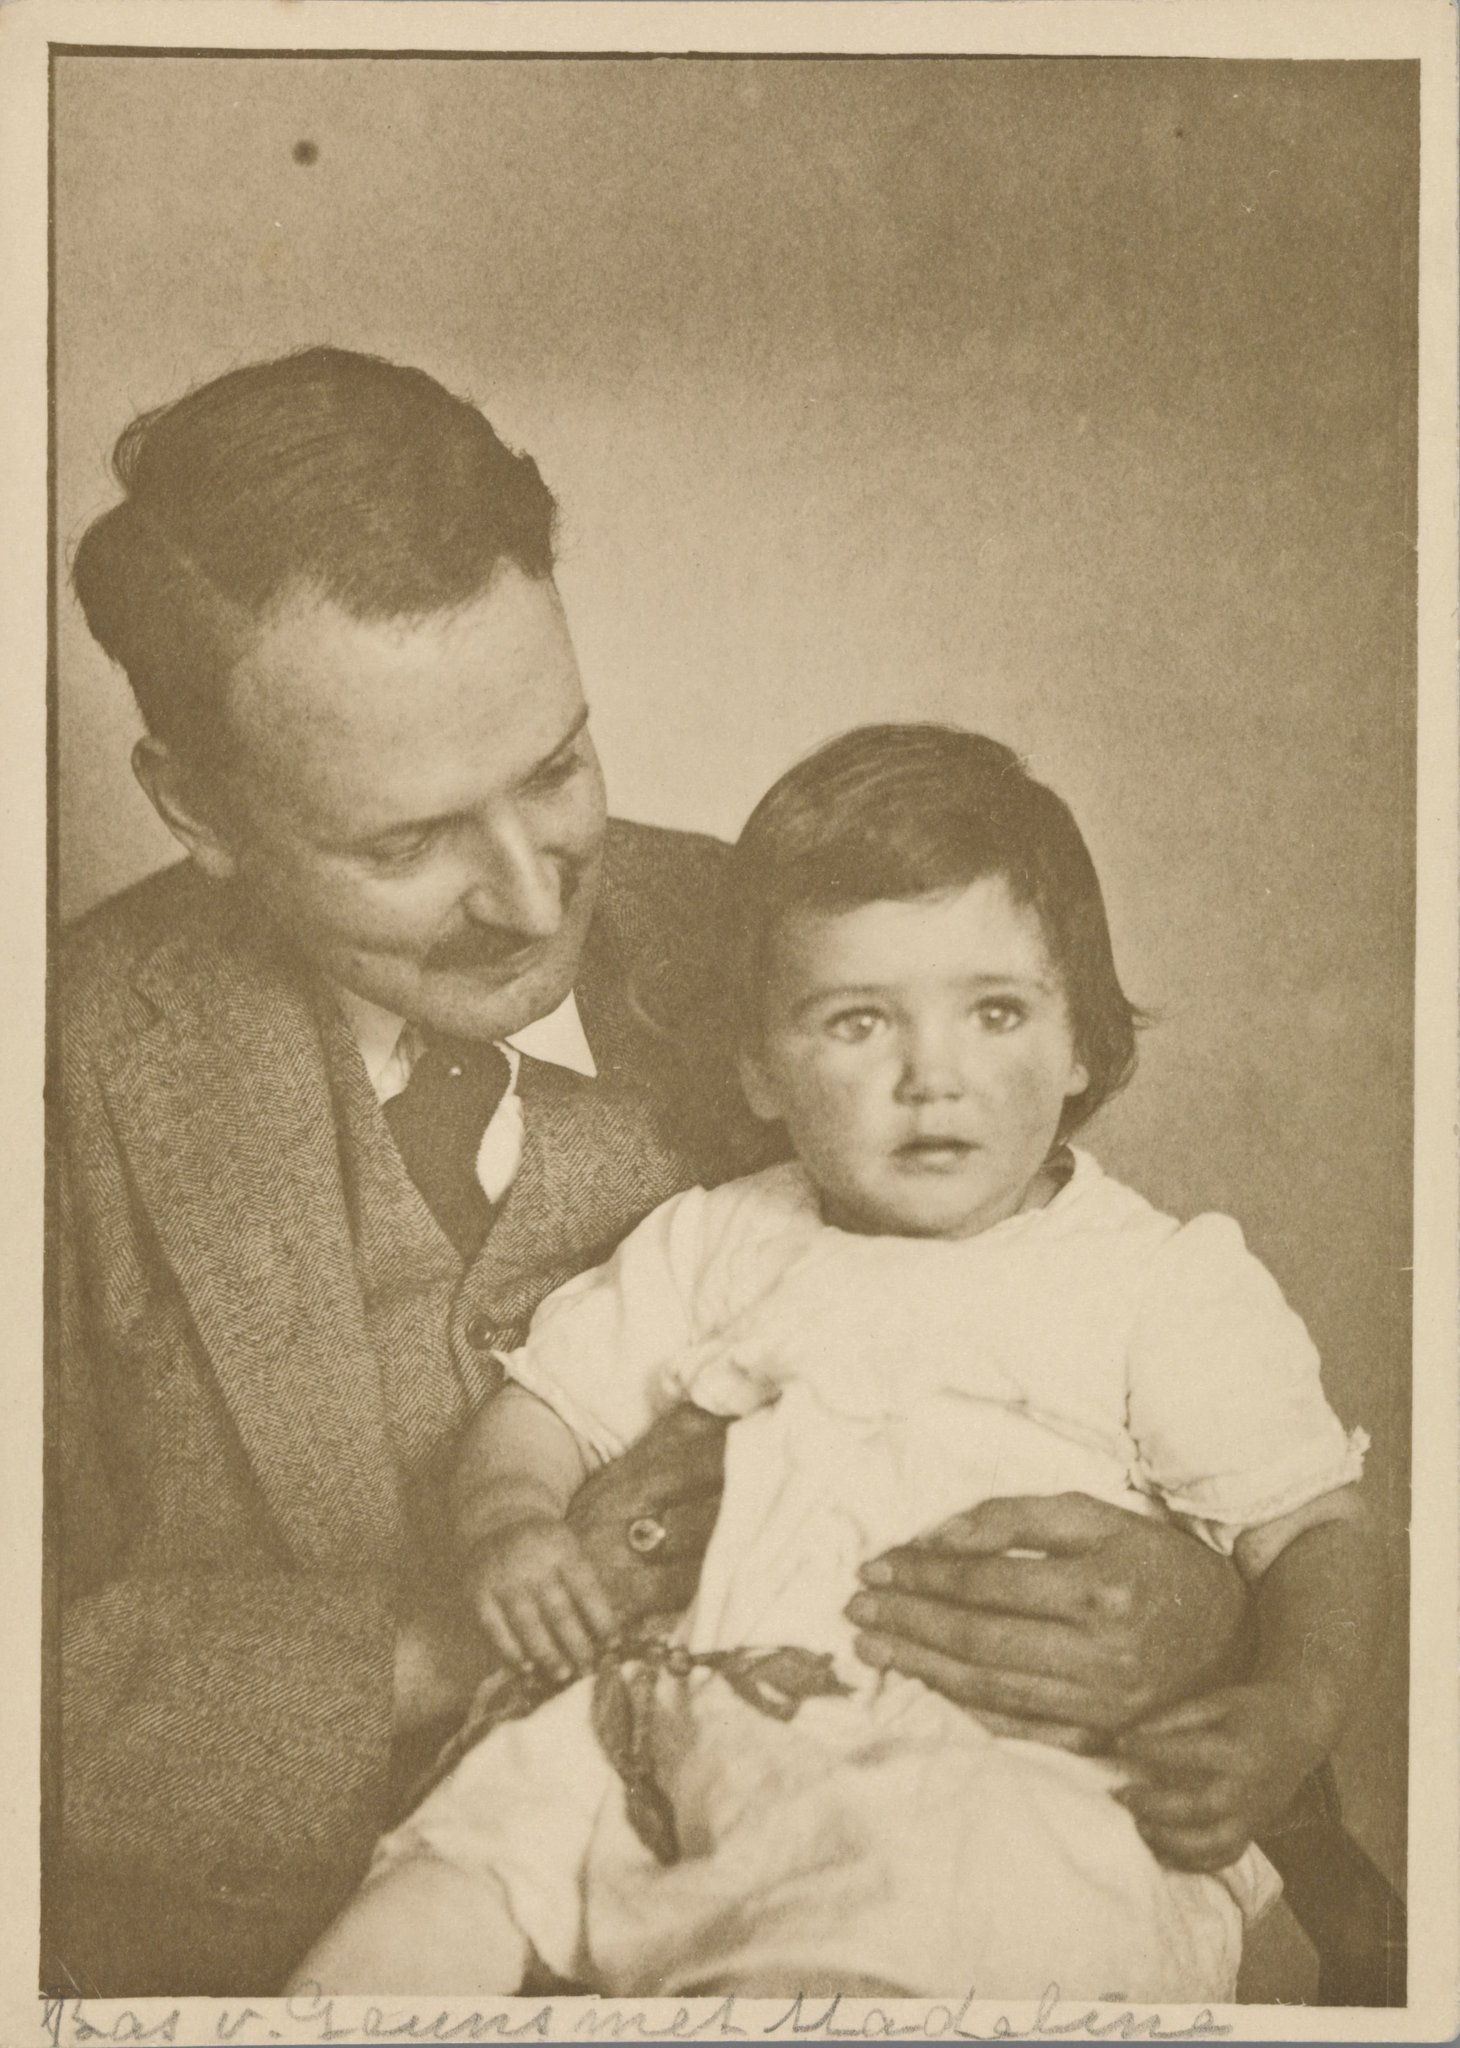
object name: photograph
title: Reproductie naar een foto, schilderij, tekening of prent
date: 1860-1915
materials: paper, photographic support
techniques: gelatin silver print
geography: netherlands